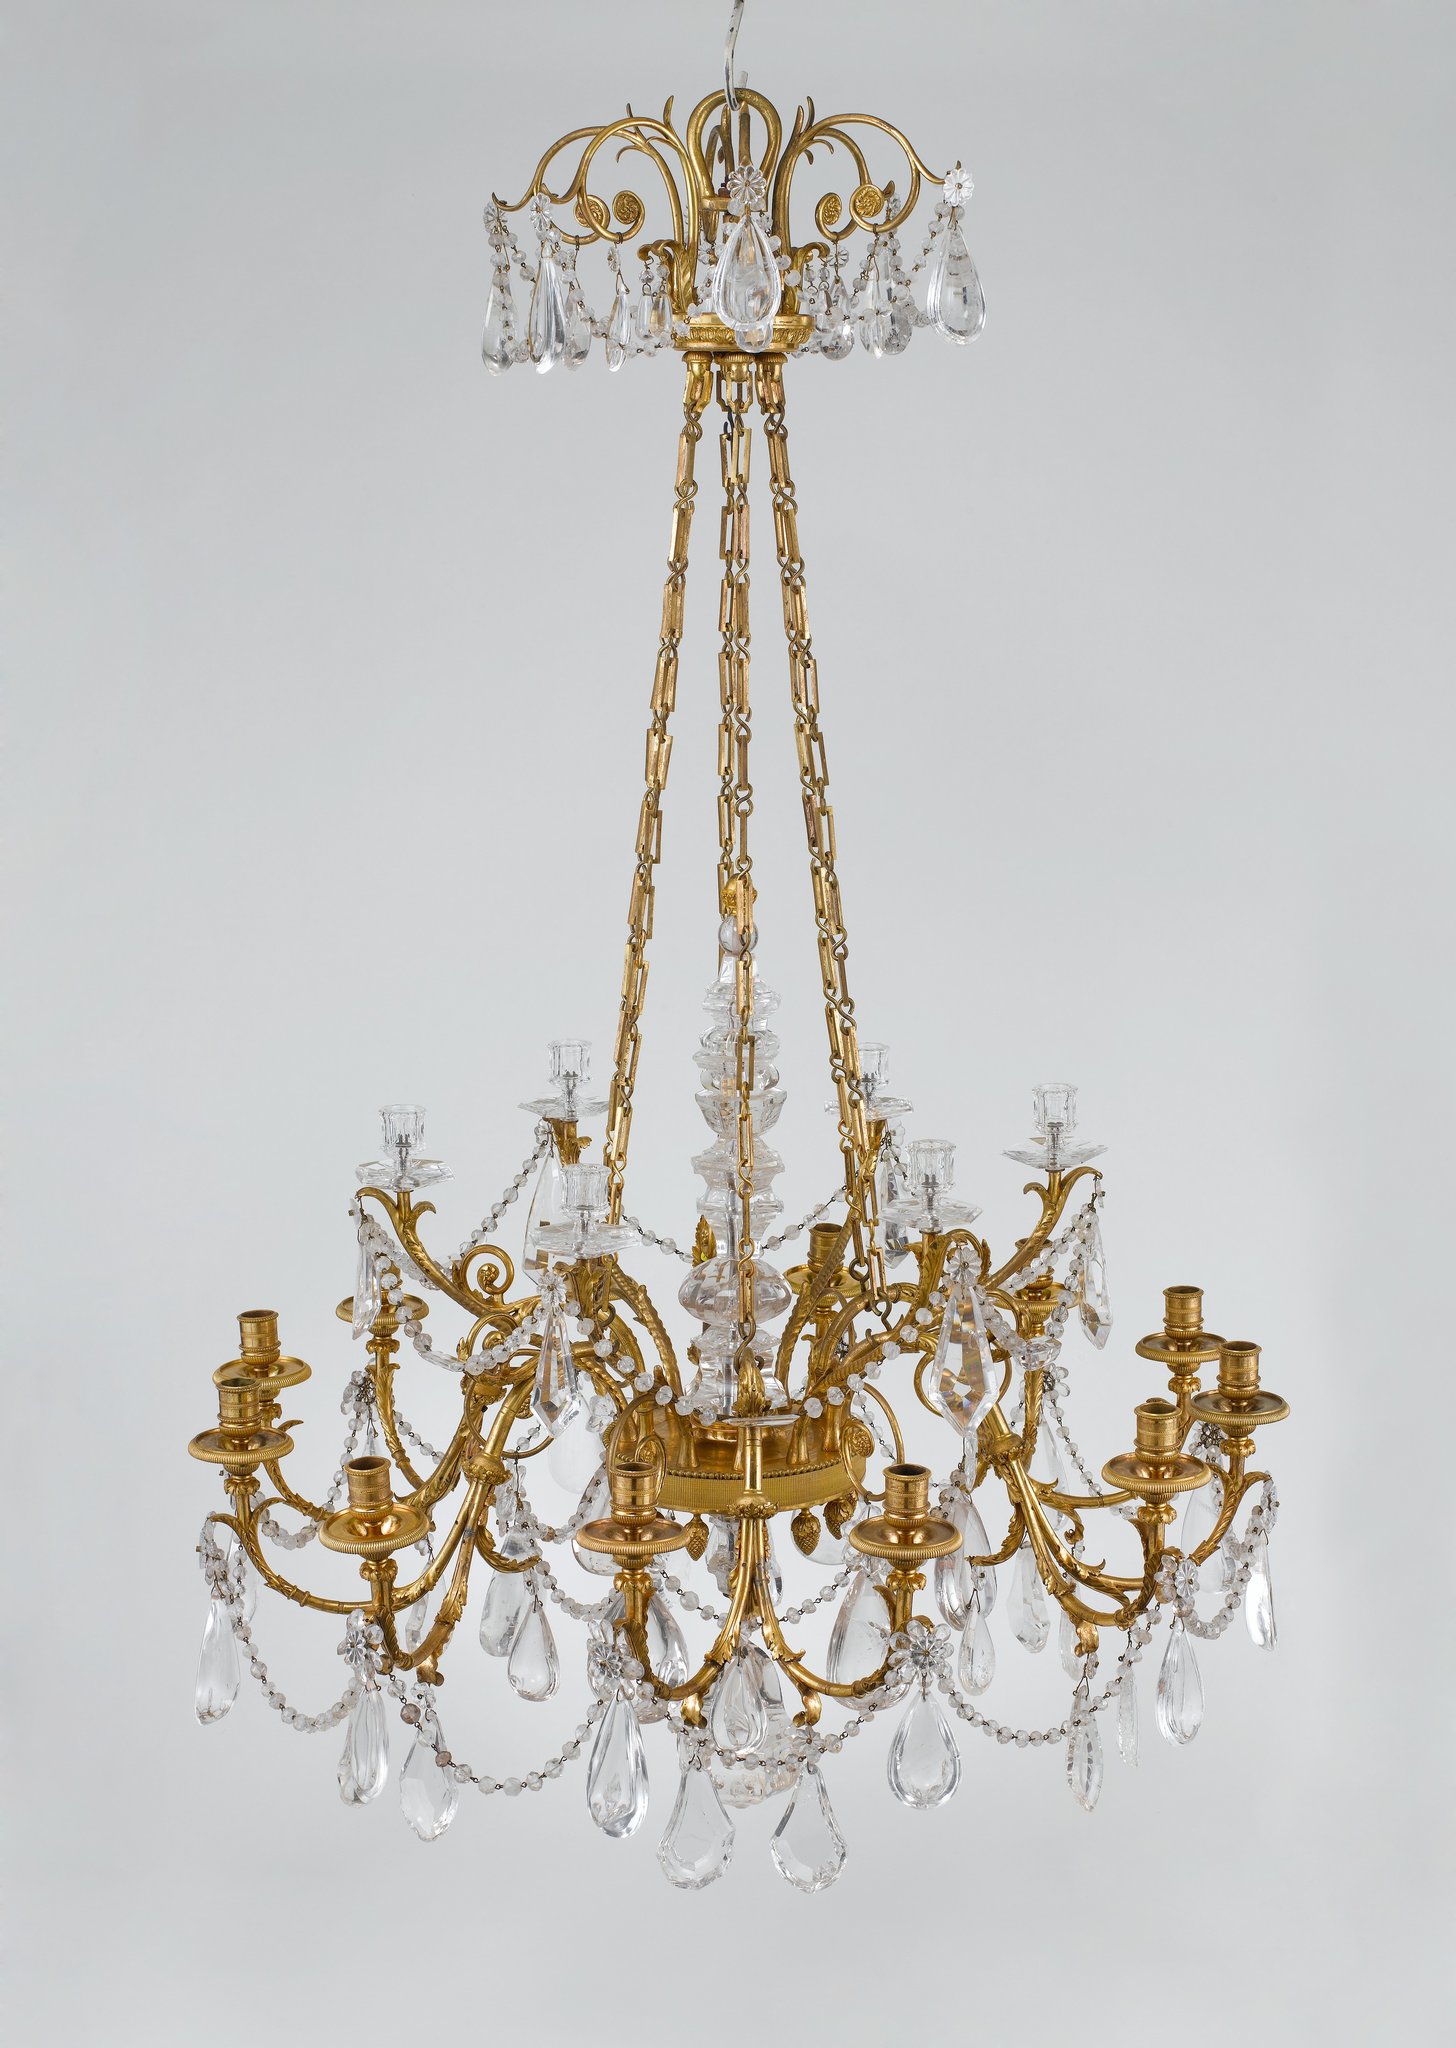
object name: chandelier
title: Eighteen-light chandelier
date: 1790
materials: gilt bronze, quartz